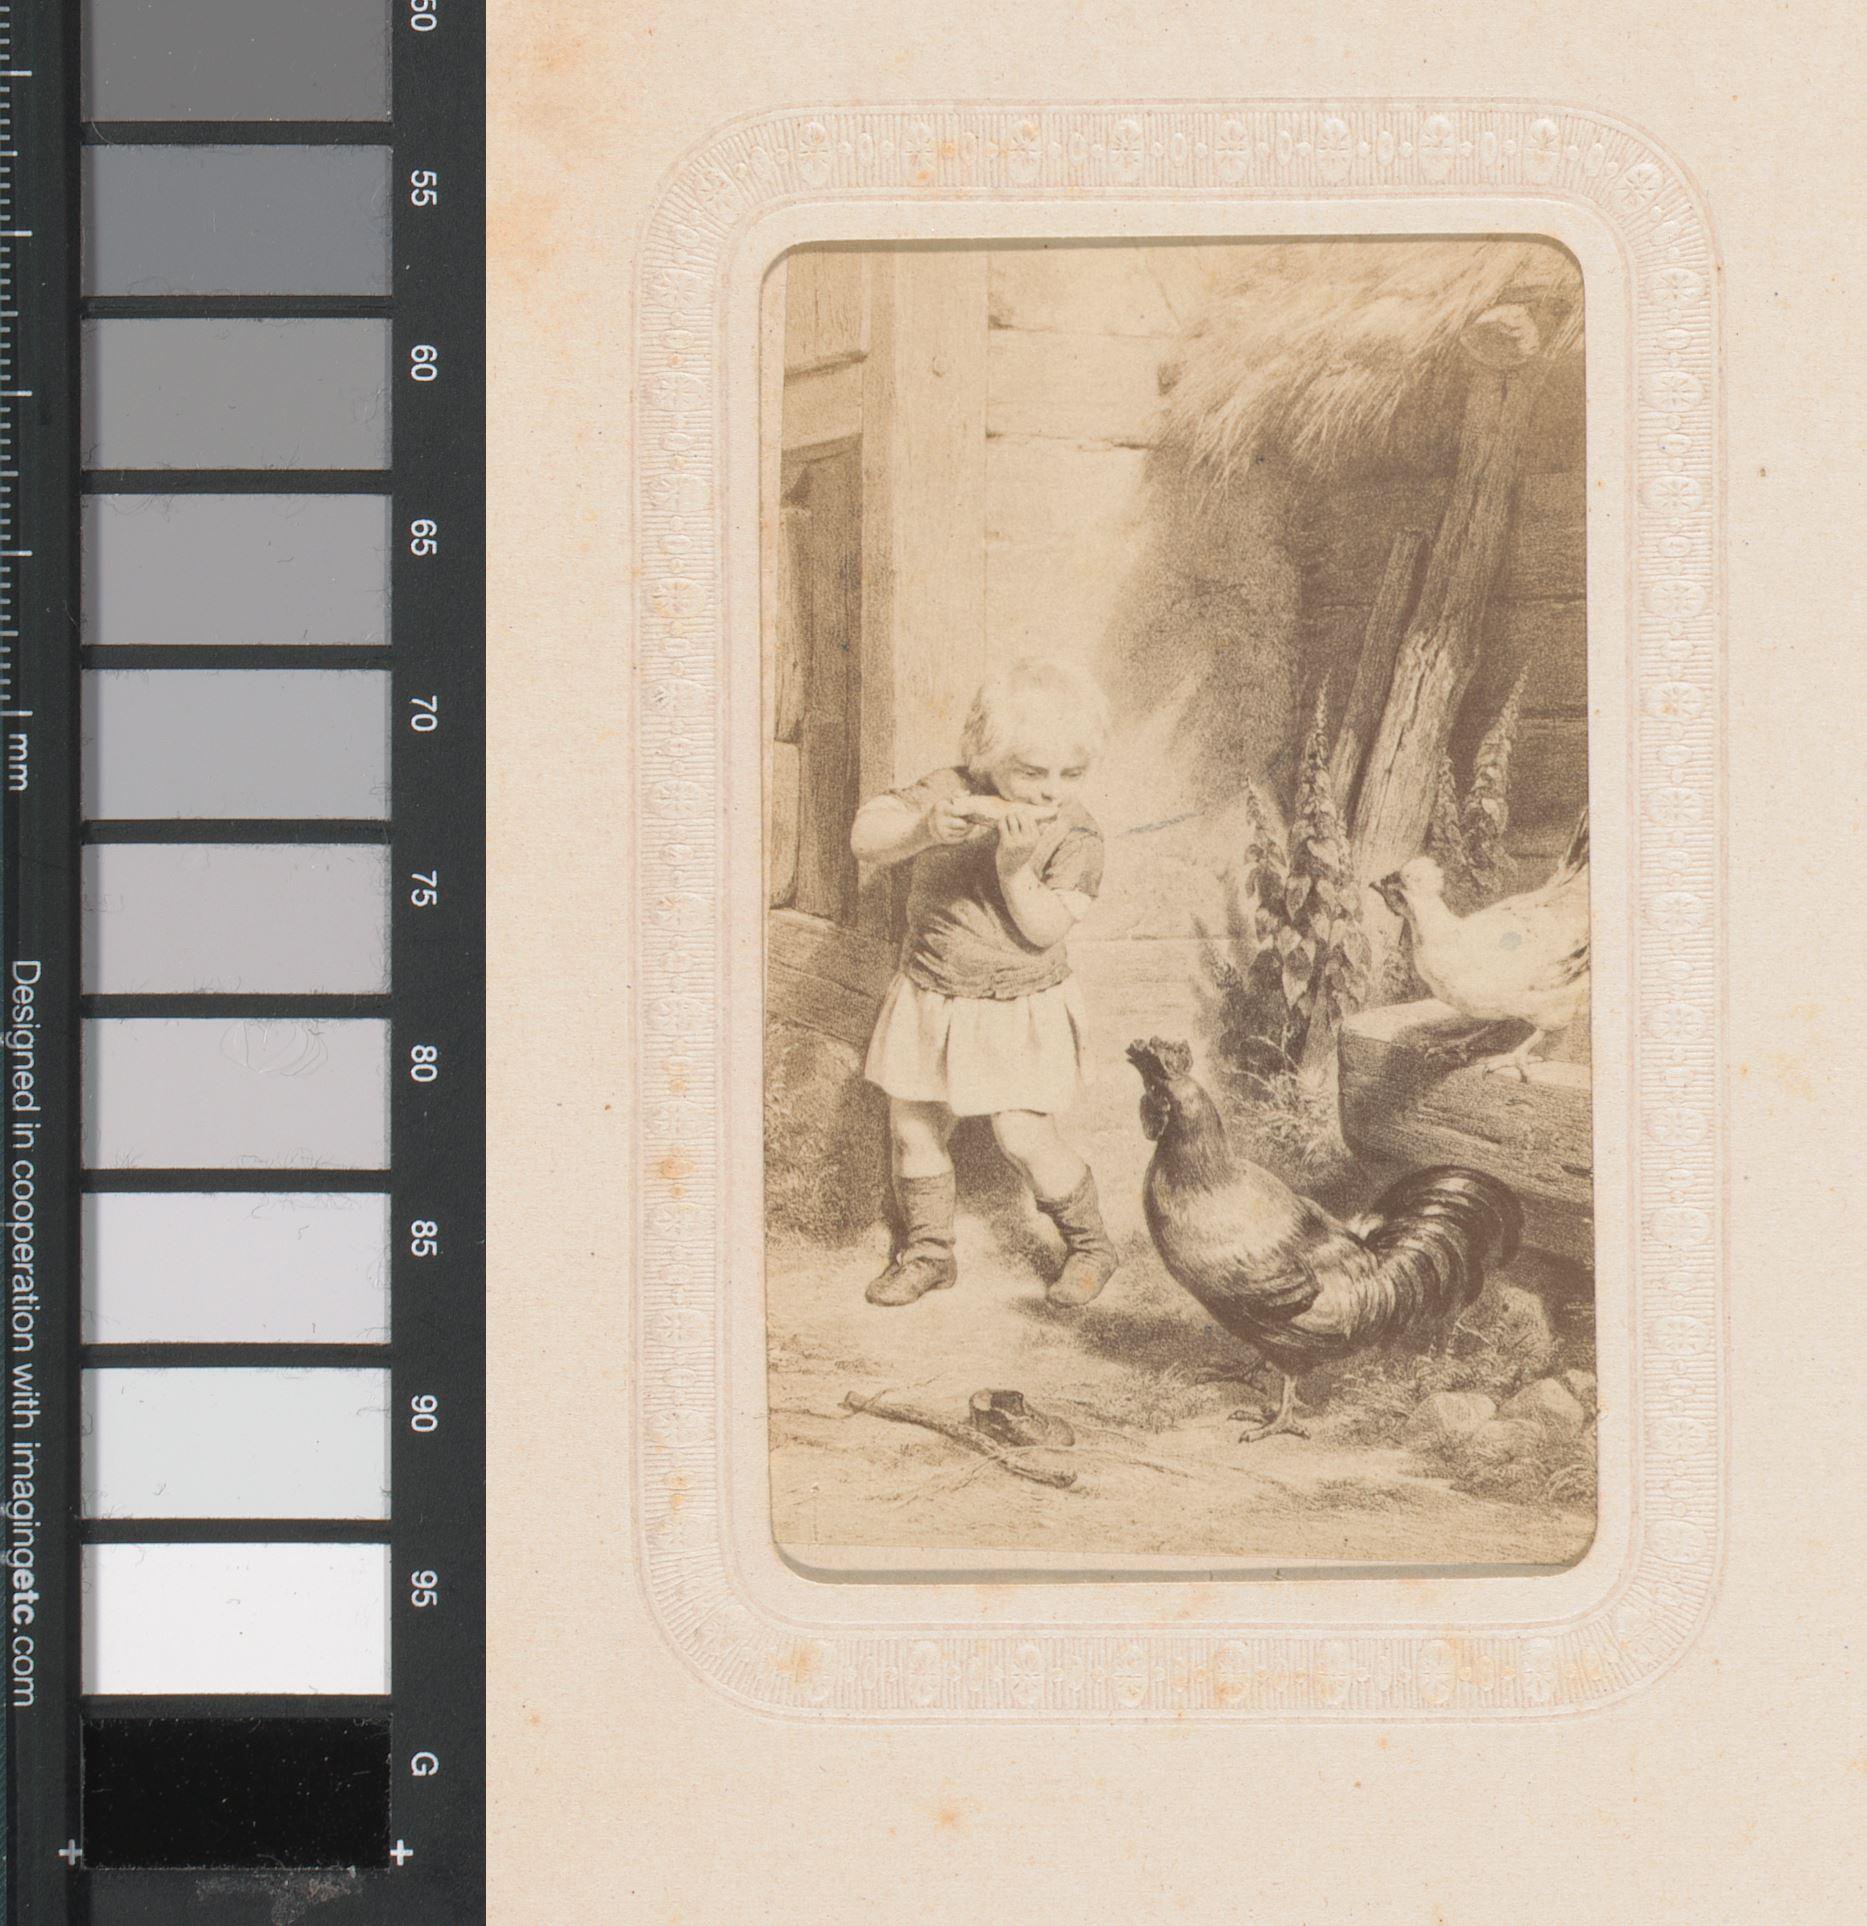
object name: carte de visite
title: Fotoreproductie van een schilderij met een kind bij een haan en een kip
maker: Anonymous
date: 1855-1865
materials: cardboard, photographic support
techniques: albumen print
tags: child, fowl (cock, hen, chicken, etc.)